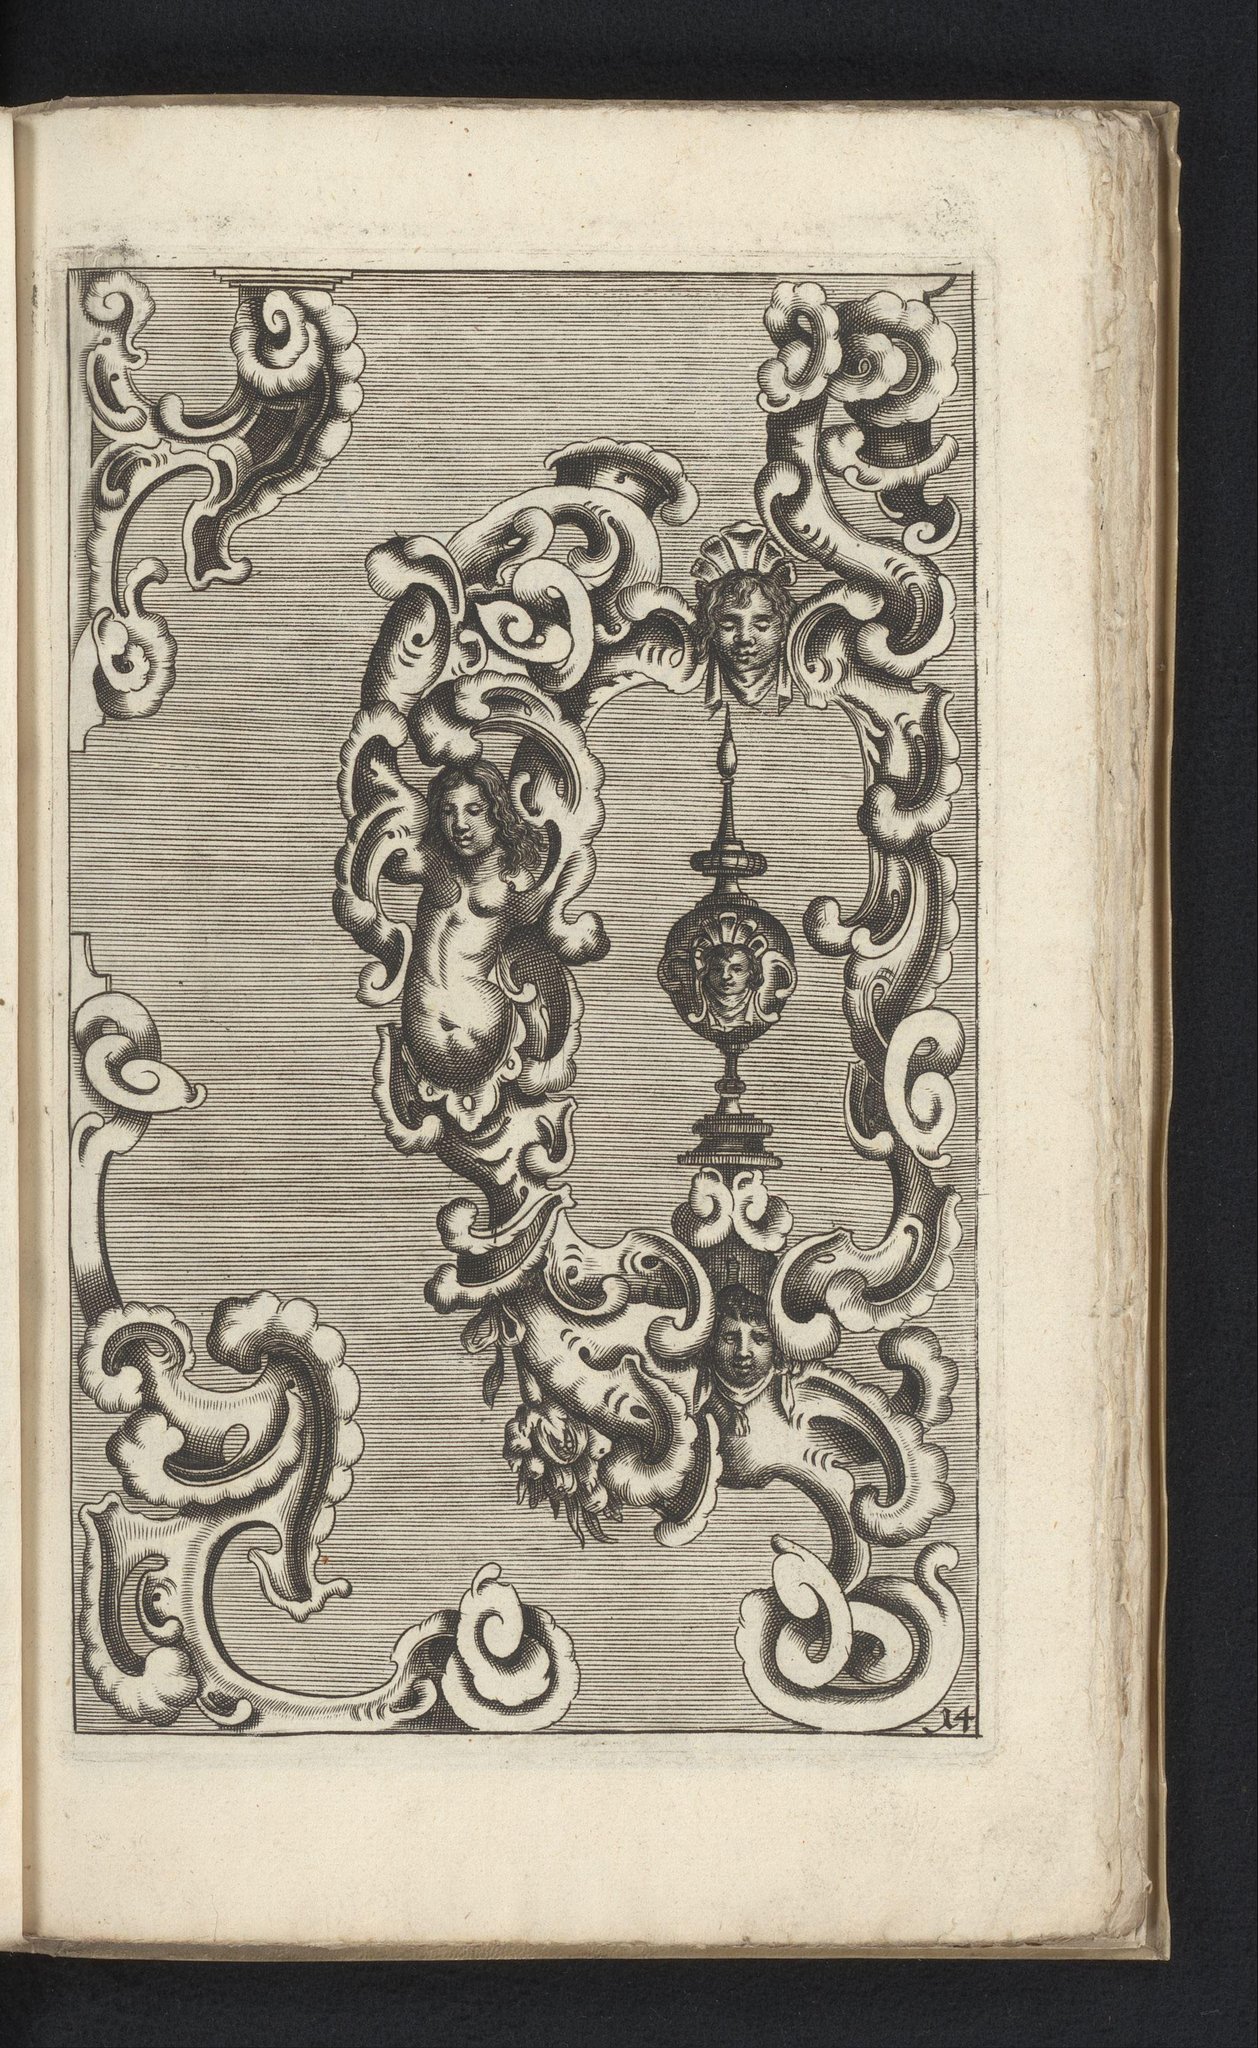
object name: ornament print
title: Neues Zierathen Buch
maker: Anonymous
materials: paper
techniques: engraving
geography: wemding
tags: auricular ornament, lobe style ~ ornament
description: Deze prent maakt deel uit van een album.